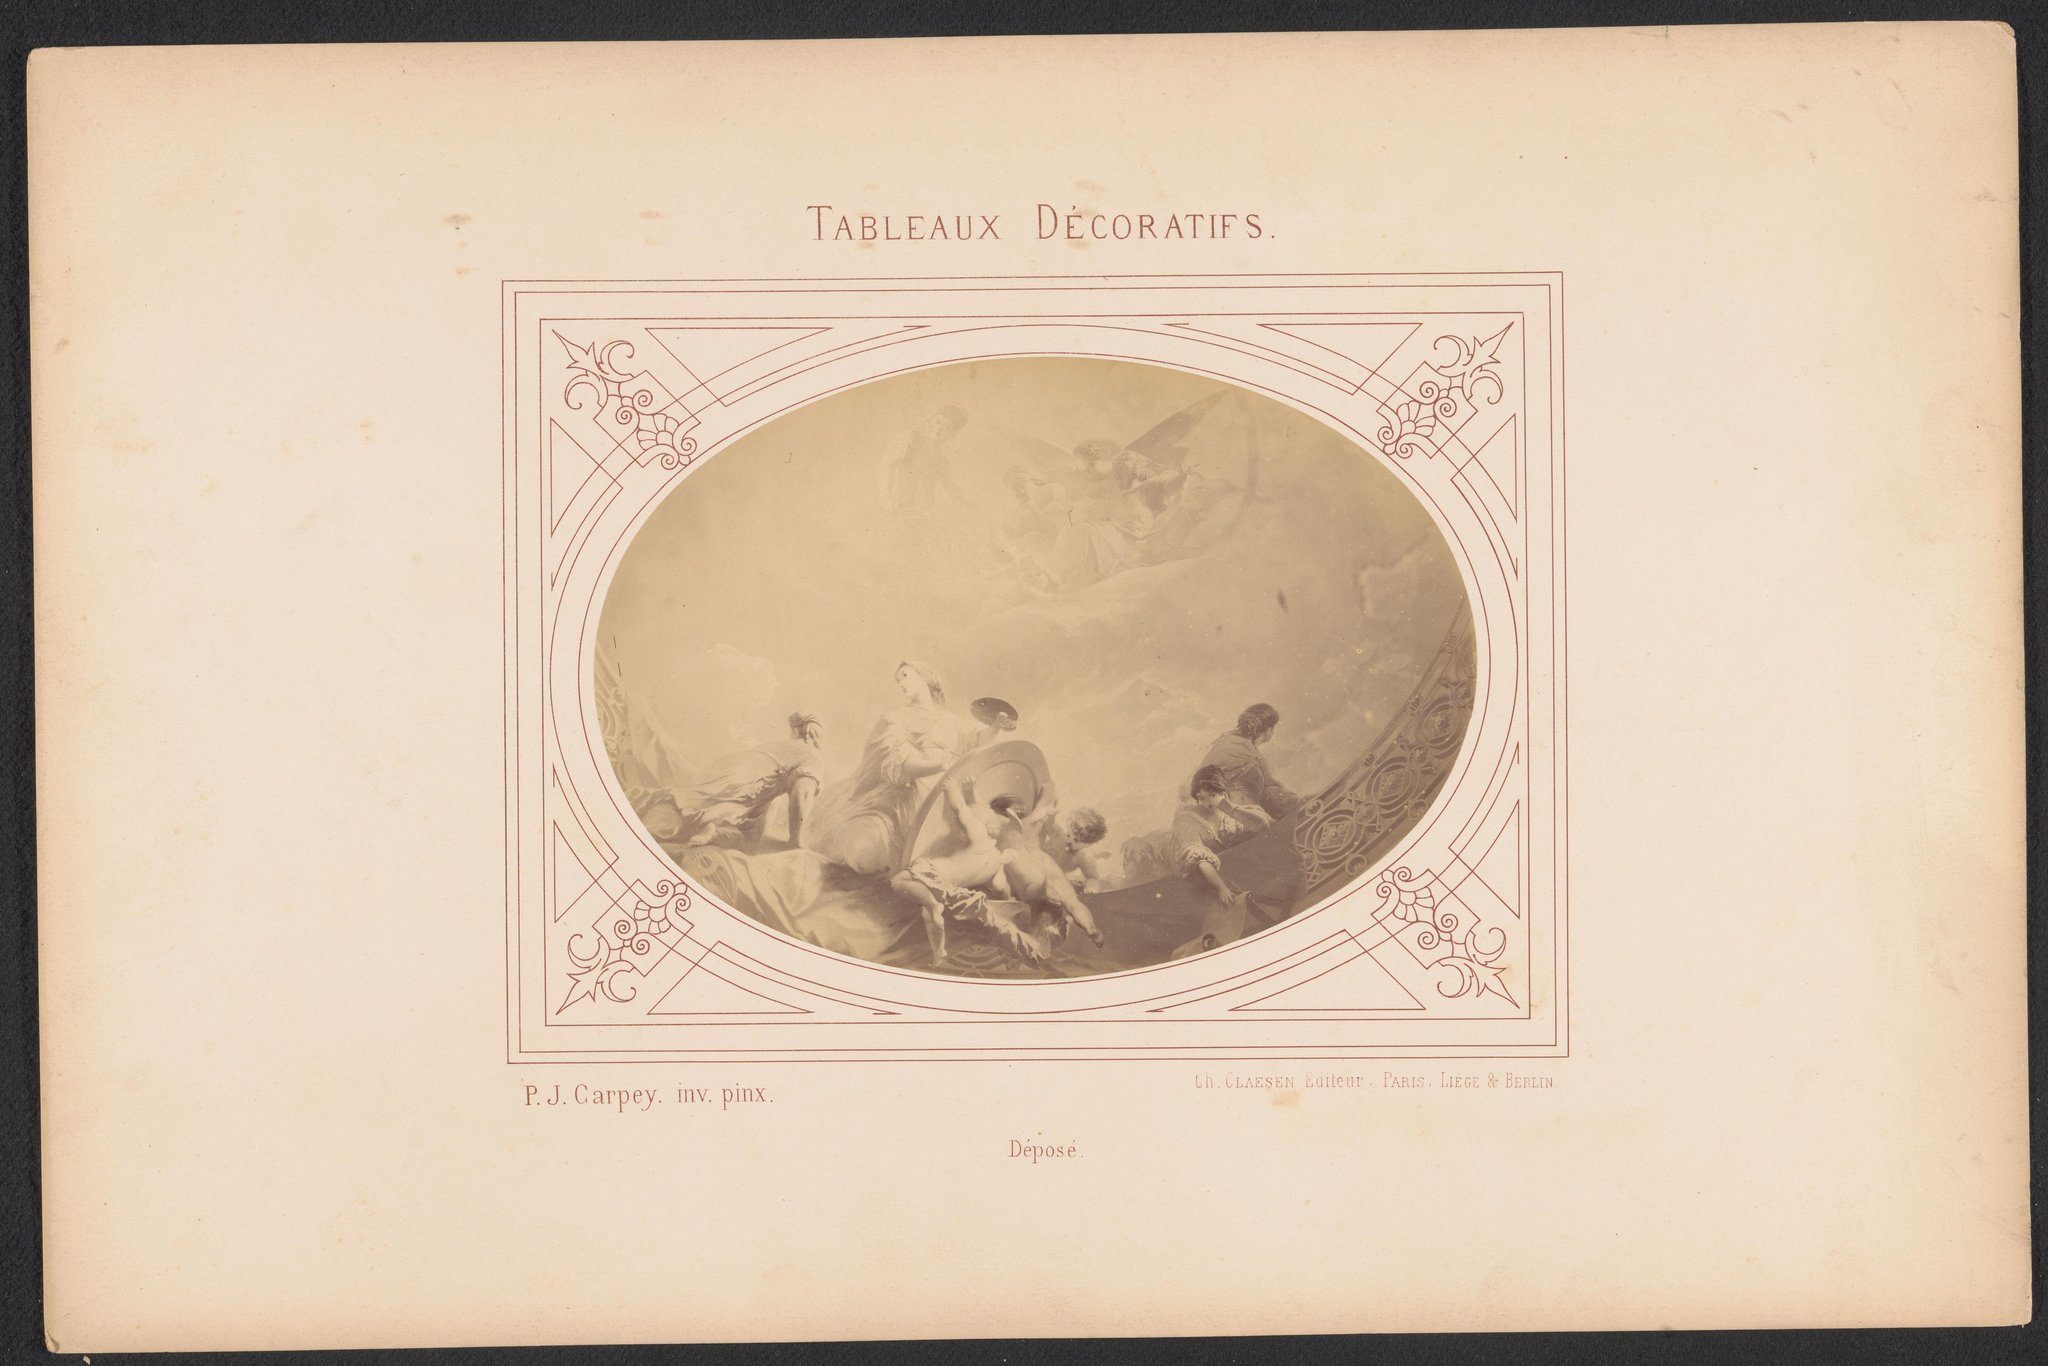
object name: photograph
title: Fotoreproductie van een schilderij van een schilderende vrouw en putti door P. J. Carpey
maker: paul-joseph carpay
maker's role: painter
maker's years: 1822-1892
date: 1874-1881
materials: photographic support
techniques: albumen print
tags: adult woman, painting (including book-illumination, miniature-painting), cupids: 'amores', 'amoretti', 'putti'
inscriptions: inscription: ‘Ch. Claesen Editeur , Paris , Liége & Berlin.’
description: Deze foto maakt deel uit van een omslag met 24 foto's op 22 bladen.